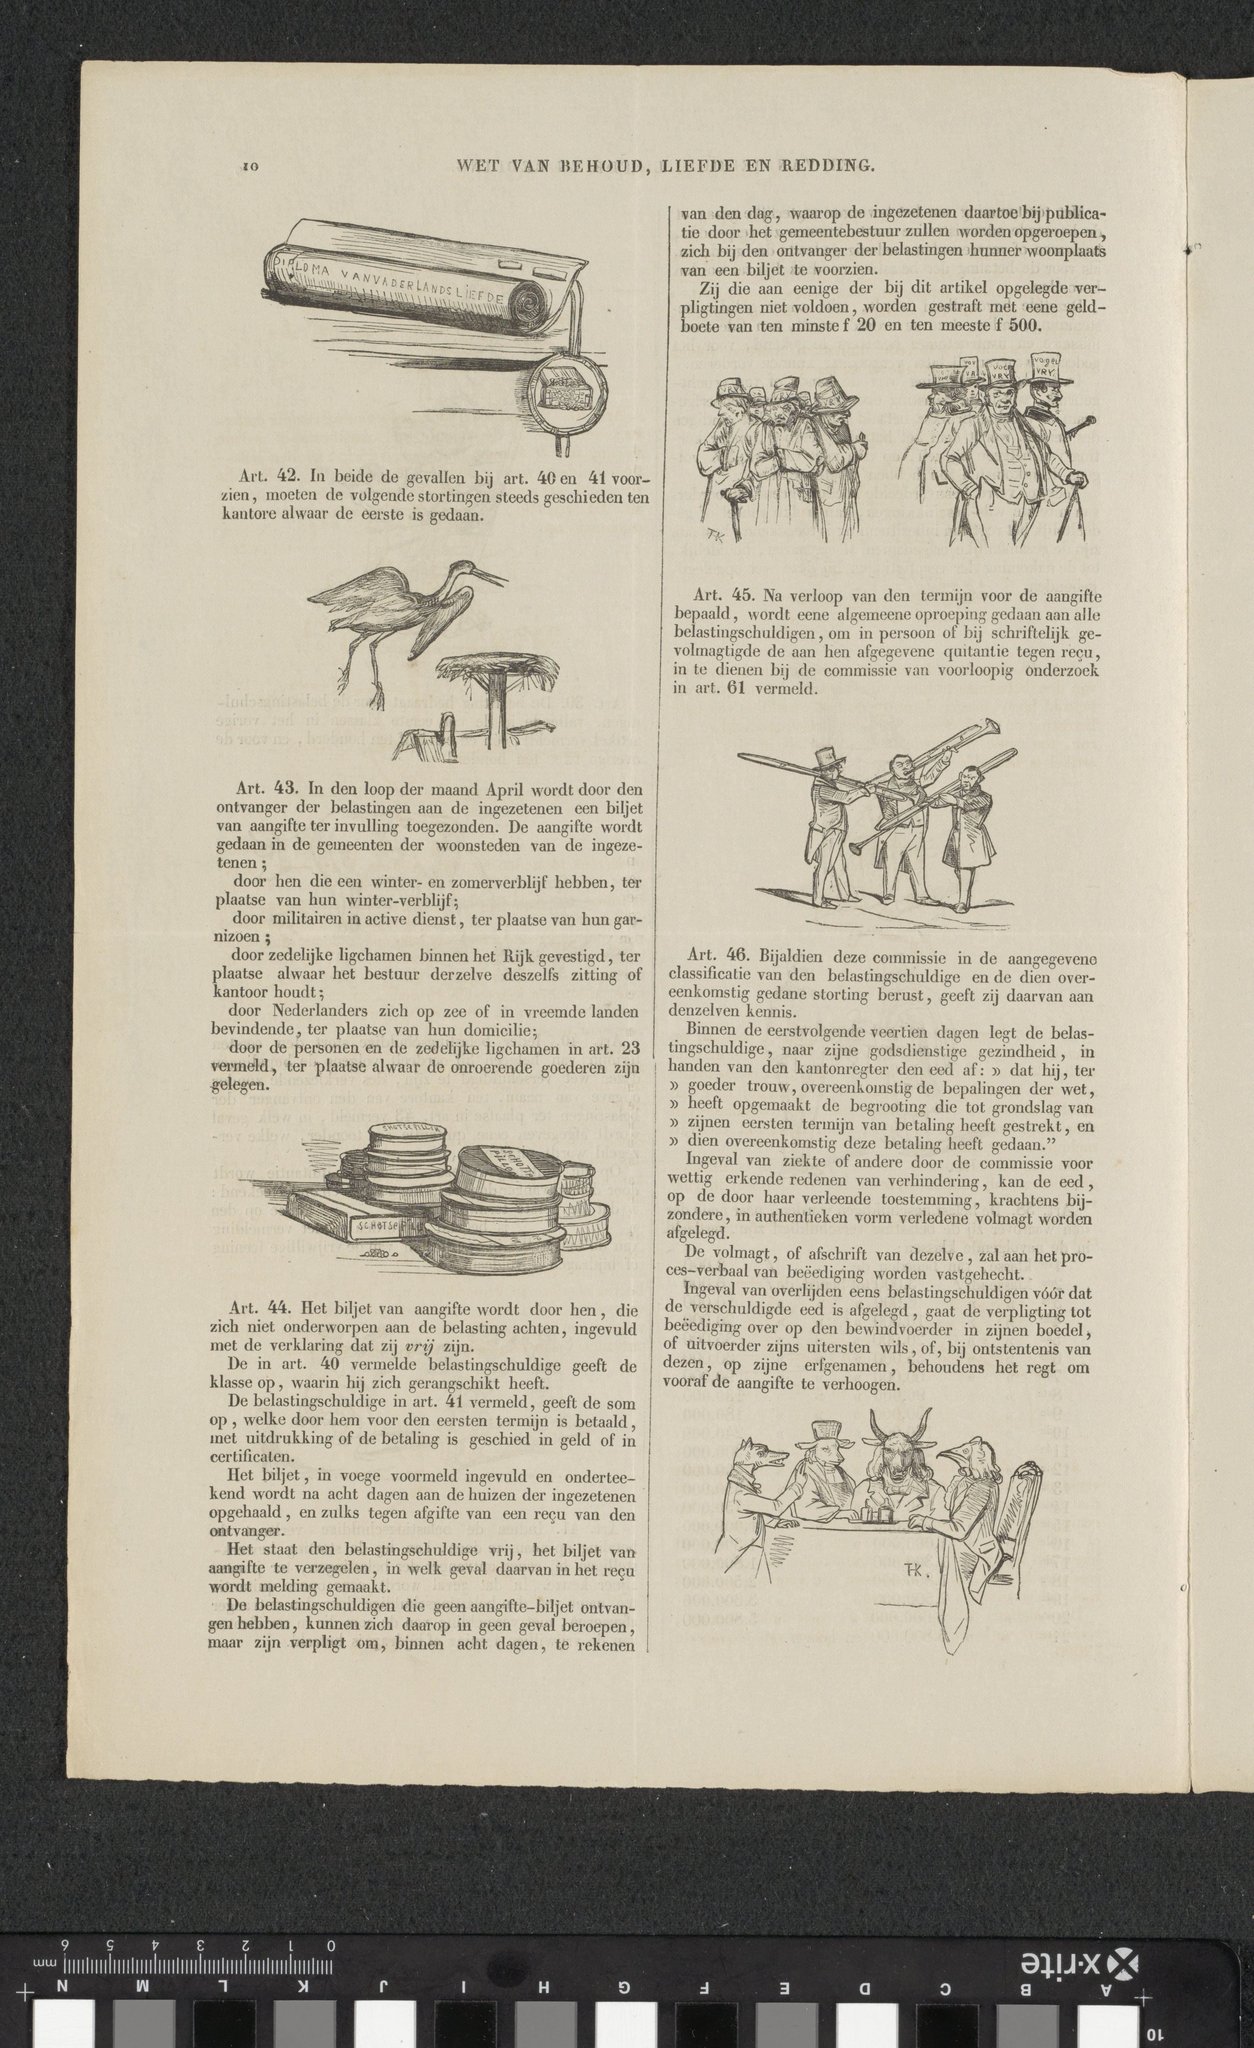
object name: print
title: Wet van Behoud, Liefde en Redding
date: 1844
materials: paper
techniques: letterpress printing, engraving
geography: the hague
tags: amsterdam, the hague, floris adriaan van hall, organization of trade and finance, taxes and financial administration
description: Bladzijde 10 met artikels 42-46 van de 'Wet van Behoud, Liefde en Redding'. Een satire in zestien bladzijden op de aansporing tot deelneming in de (zogenaamde) vrijwillige 3% geldlening uitgeschreven in maart 1844 door minister F.A. van Hall. Binnenzijde van een dubbelgevouwen blad bedrukt op alle zijden.